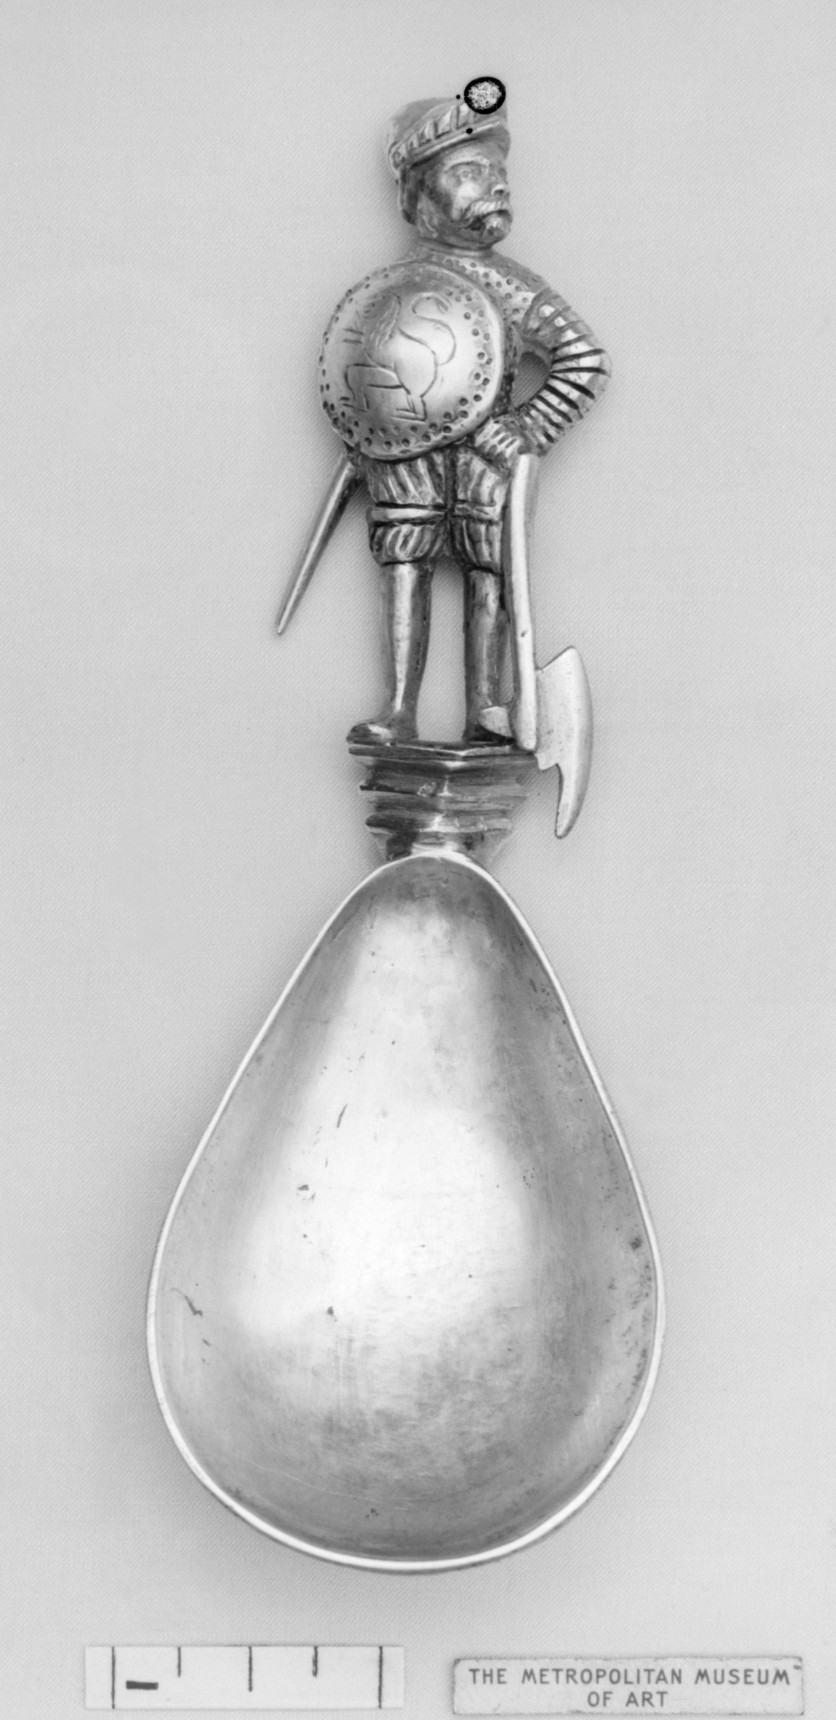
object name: spoon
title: Figure-top spoon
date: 1551-1600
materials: gilt, silver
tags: men